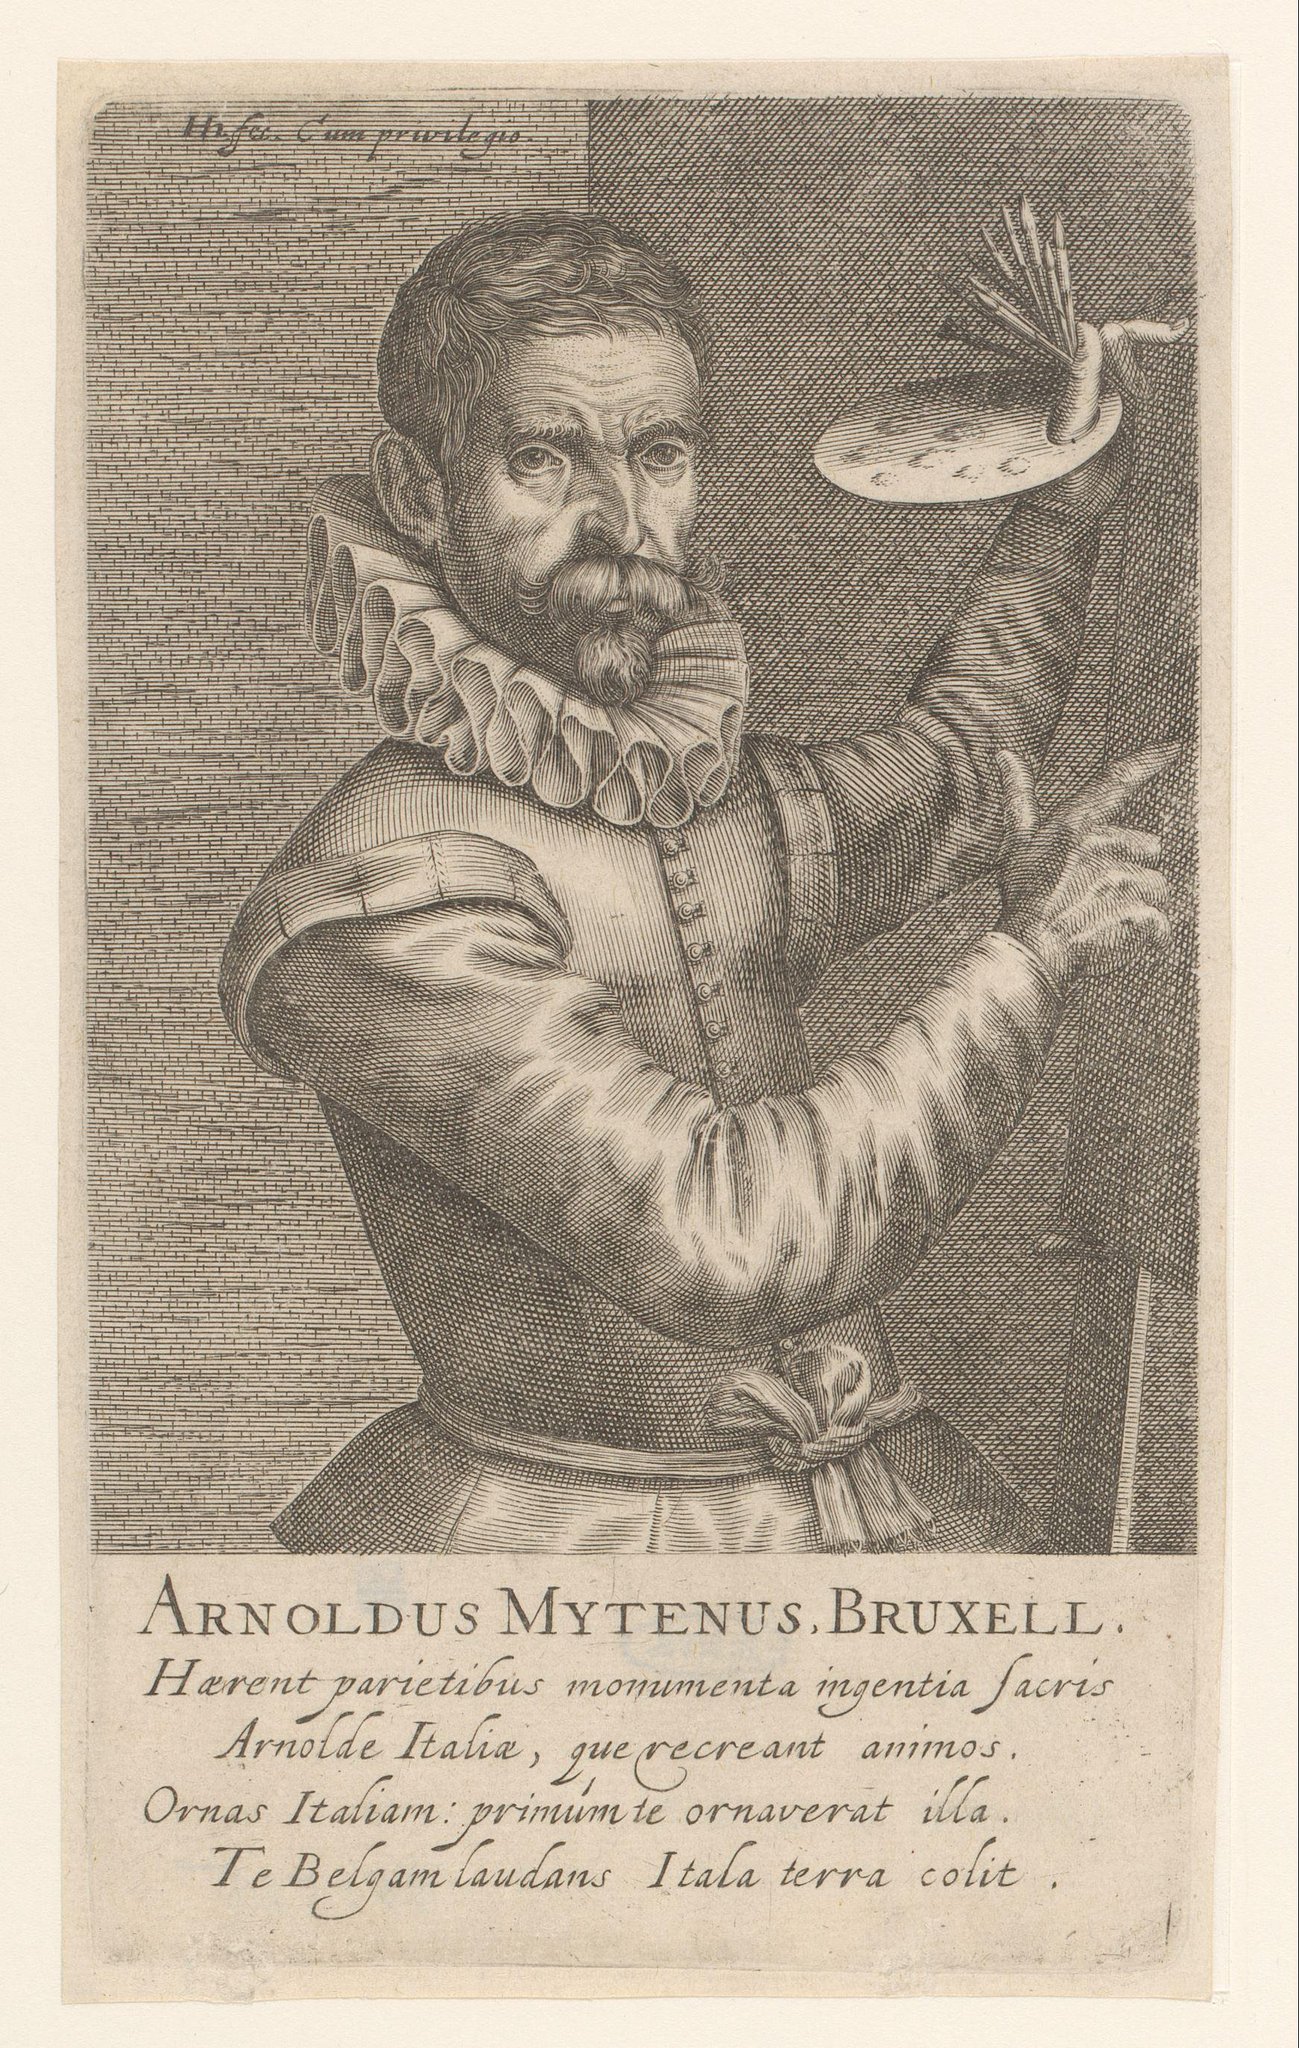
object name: print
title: Portret van Arnold Mytens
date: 1610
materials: paper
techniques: engraving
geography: the hague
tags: painter, historical persons, portrait, self-portrait of painter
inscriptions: collector's mark: Lugt 2228, collector's mark: Lugt 2760